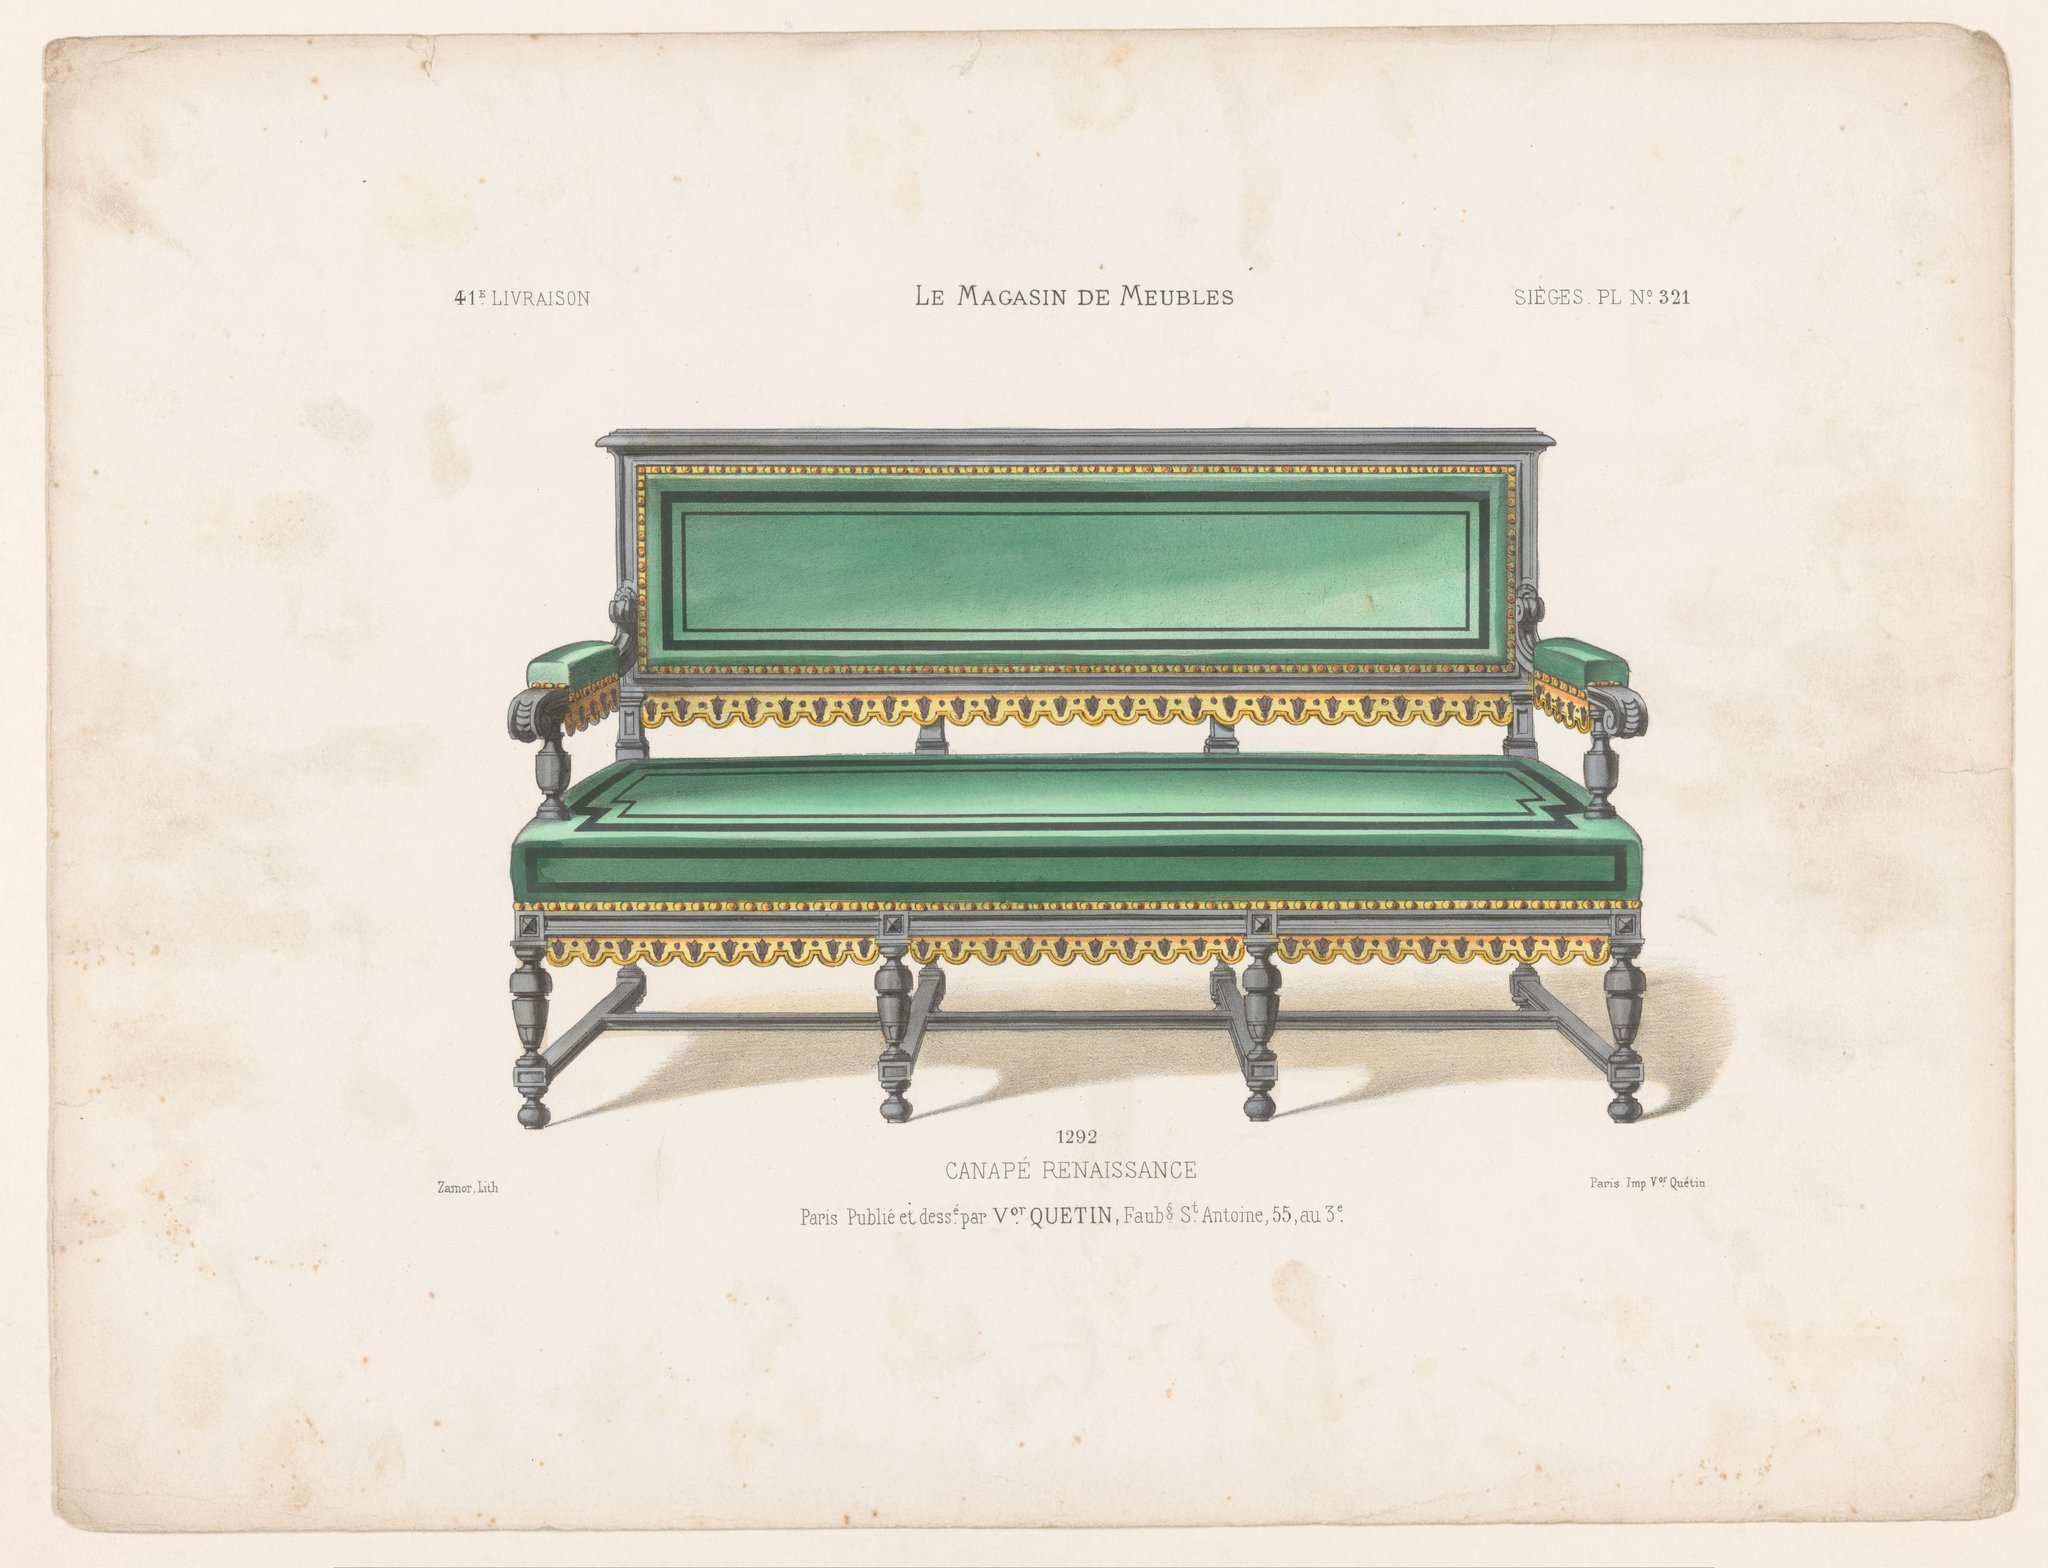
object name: print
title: Canapé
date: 1832-1877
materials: paper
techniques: hand coloring, lithograph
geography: paris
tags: seating furniture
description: Een renaissance canapé. Prent uit 41e Livraison.